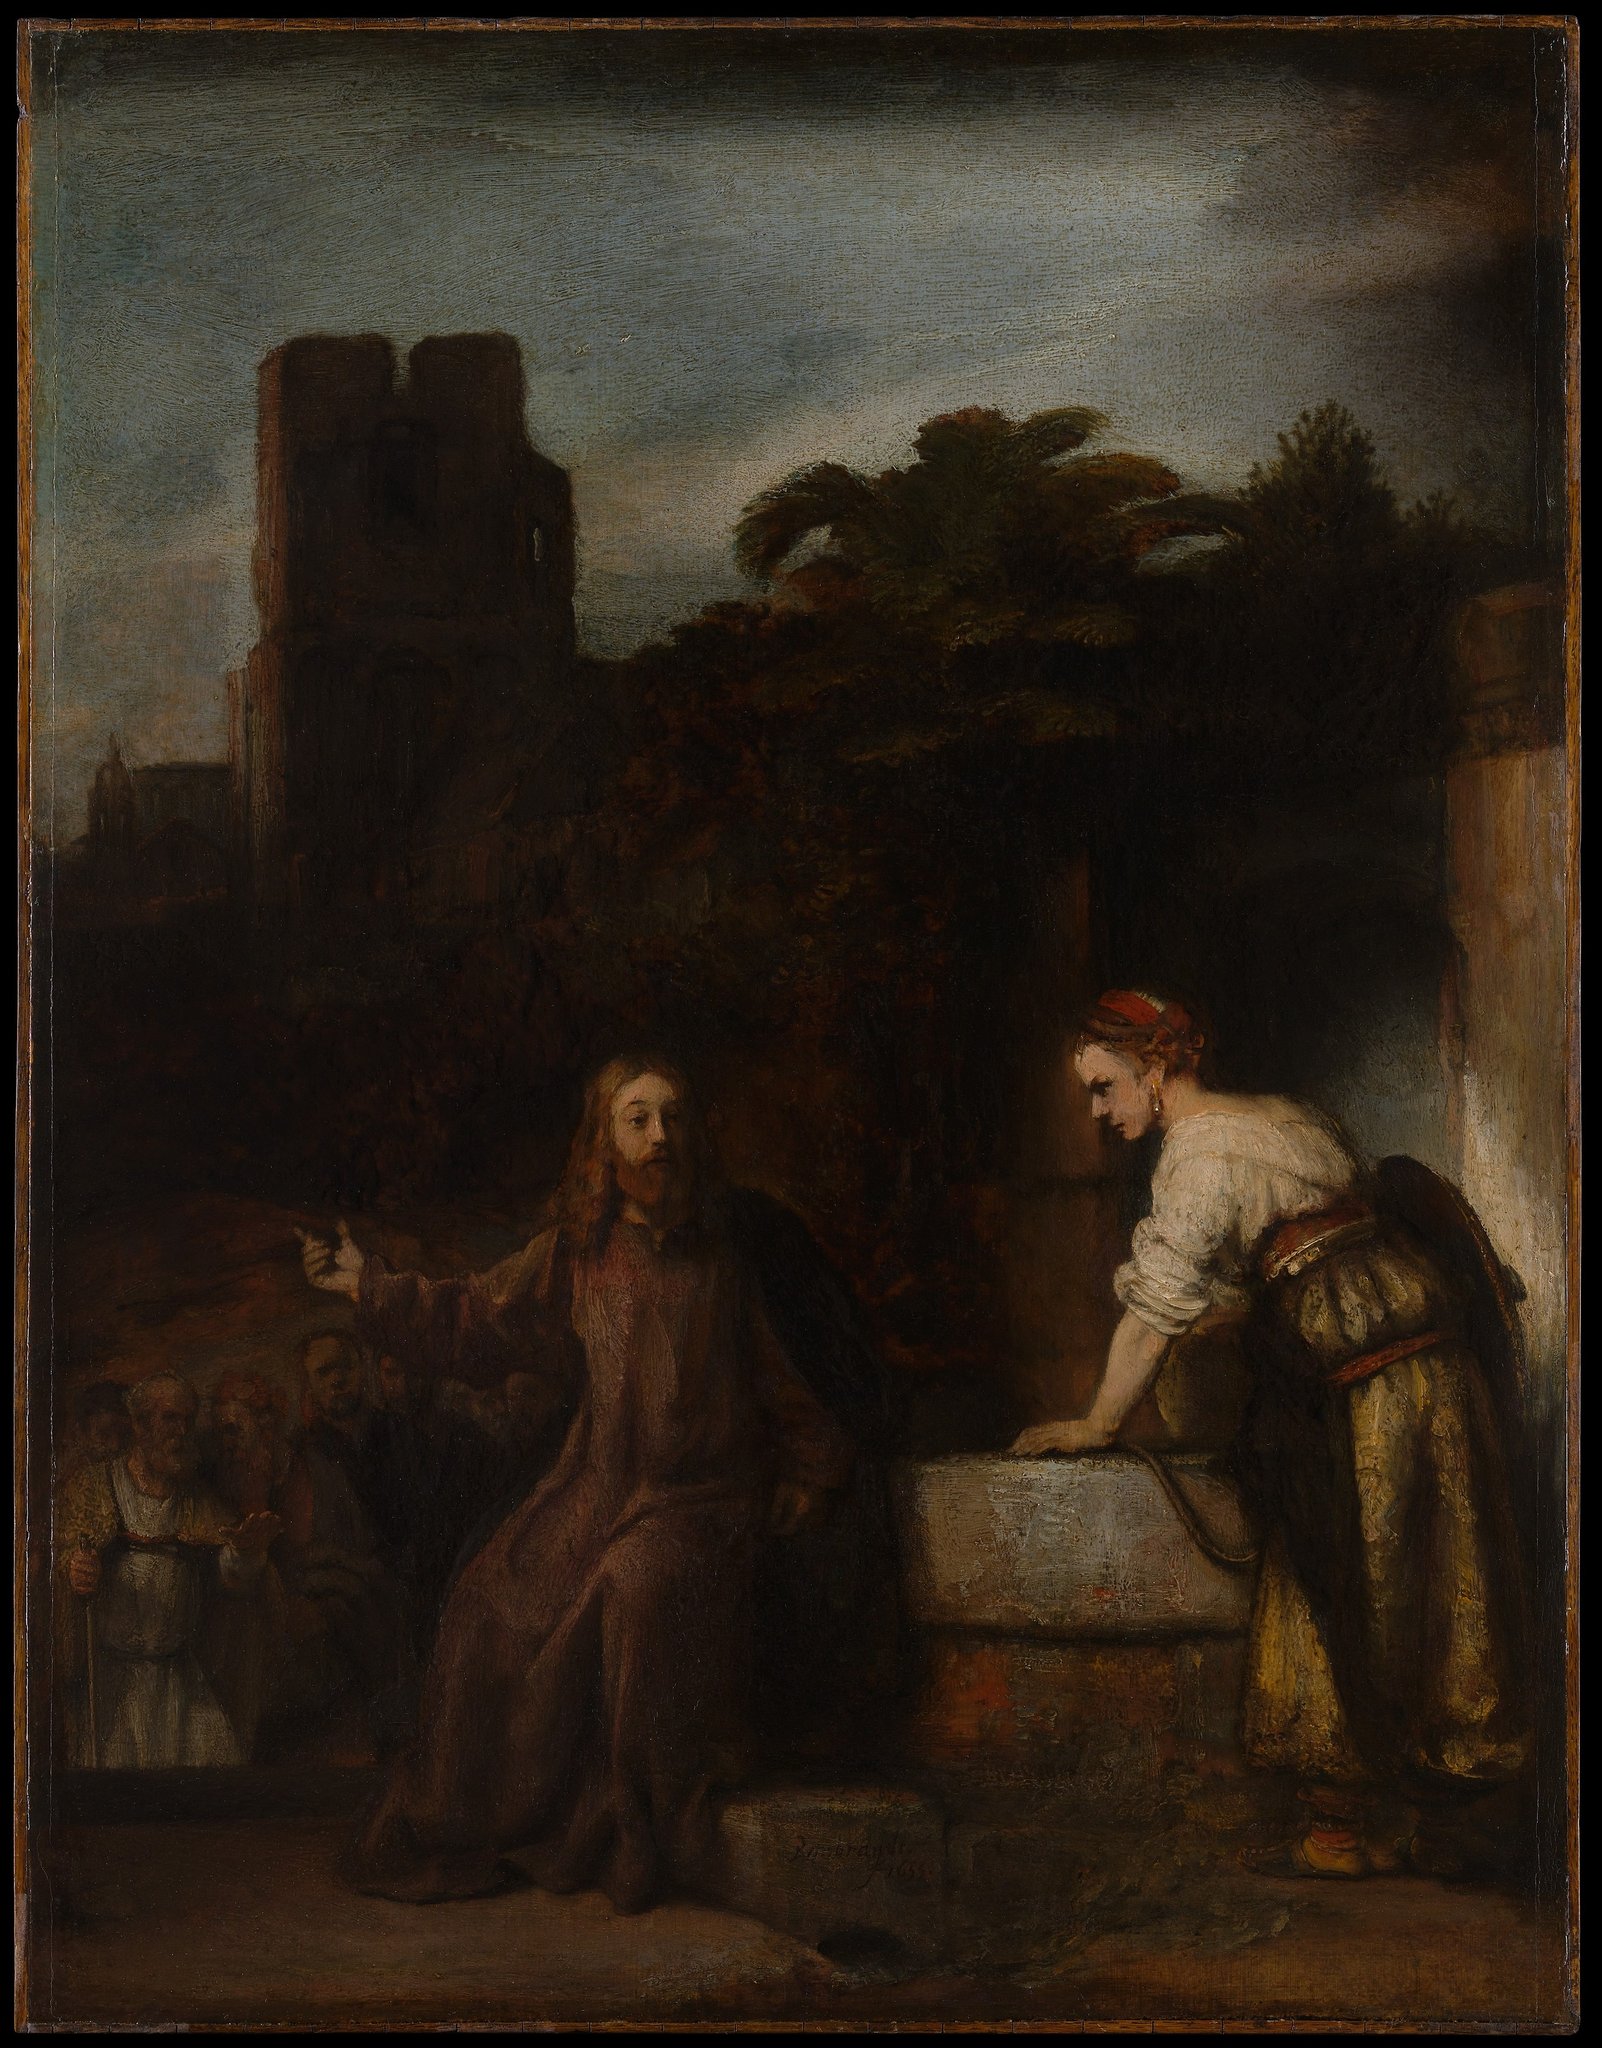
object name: painting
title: Christ and the Woman of Samaria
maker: rembrandt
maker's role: artist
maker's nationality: dutch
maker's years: 1606-1669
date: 1650-1660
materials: oil, wood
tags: men,women,christ